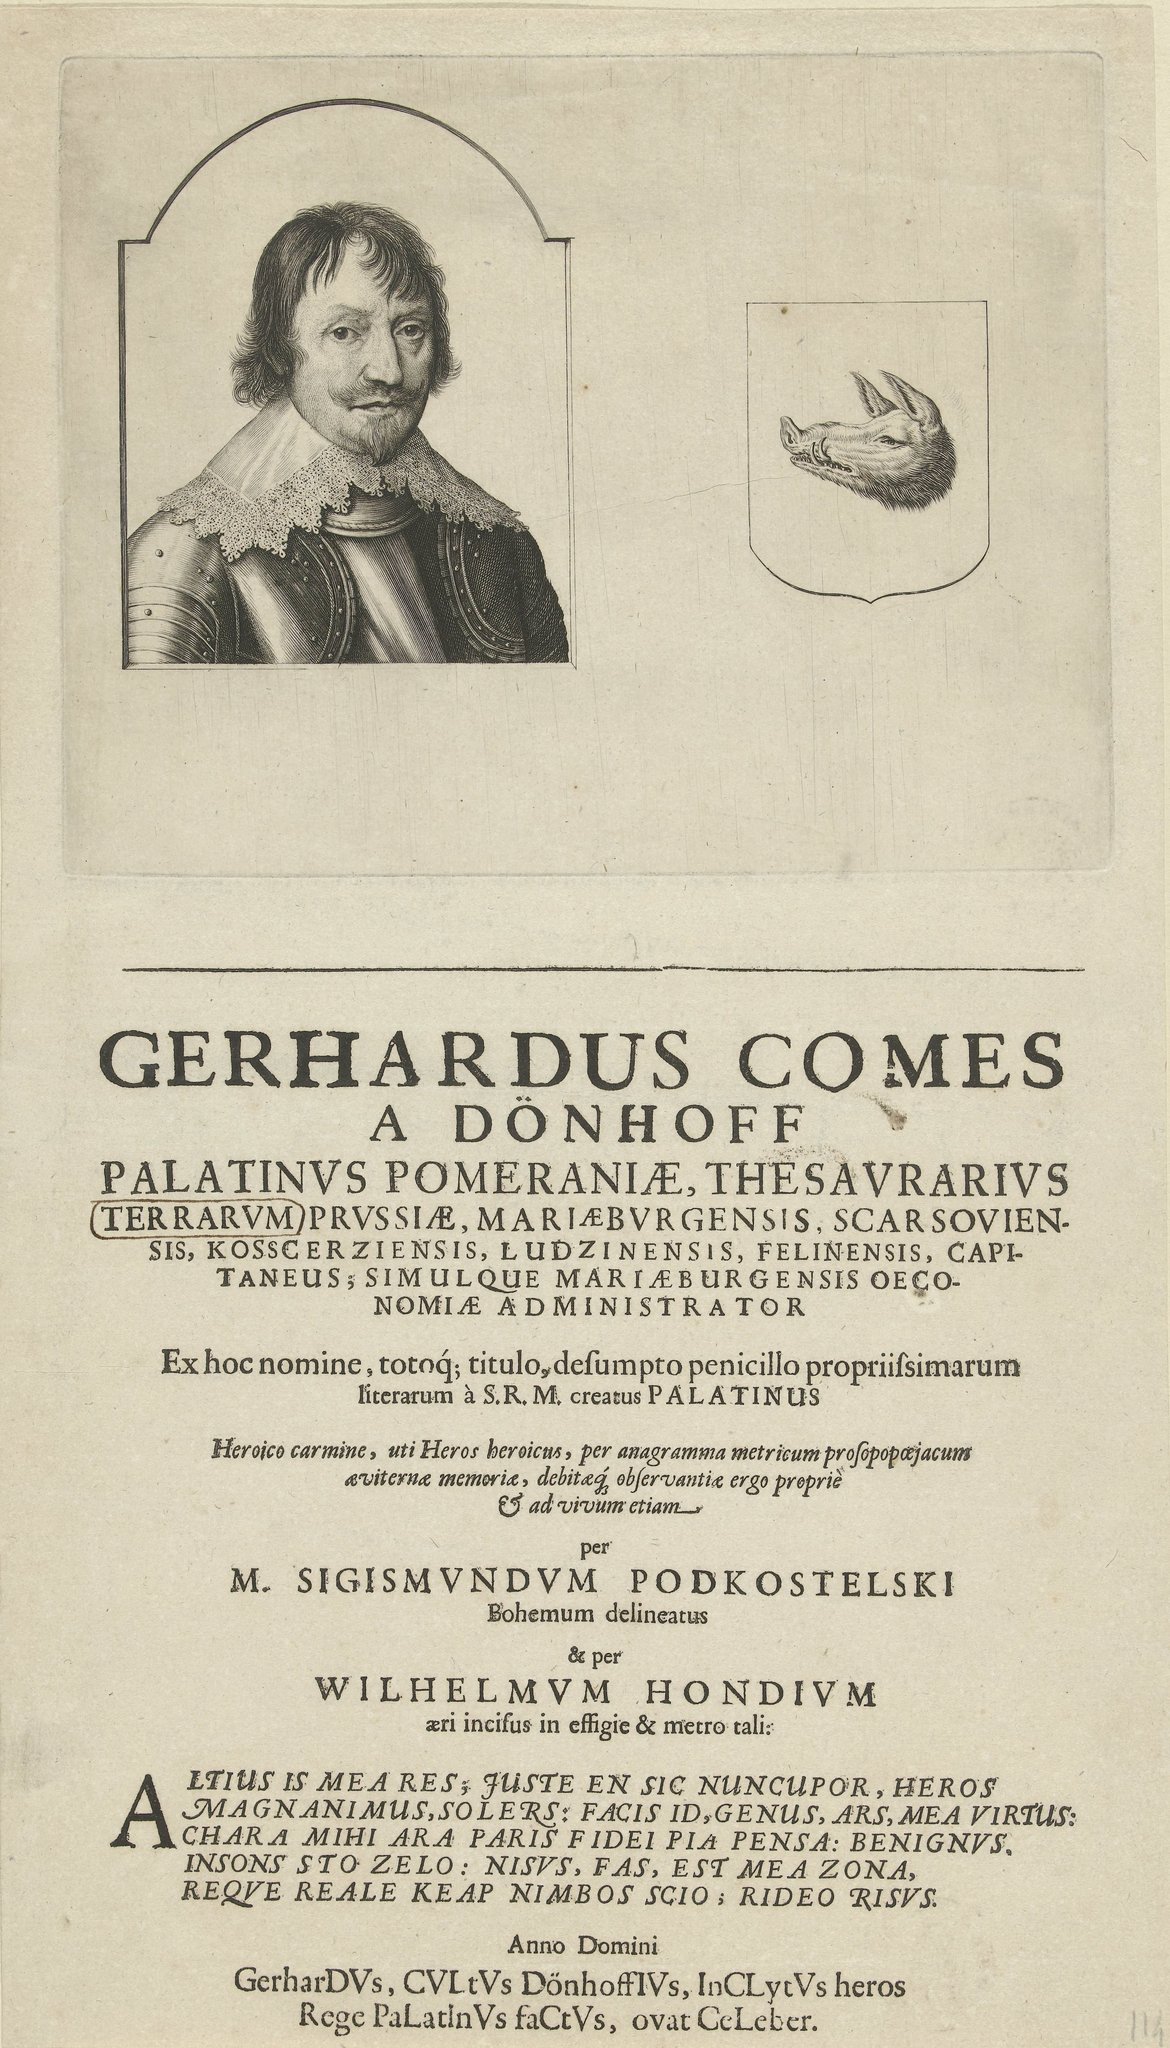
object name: print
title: Portret van Gerard, graaf van Dönhoff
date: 1641-1658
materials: paper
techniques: engraving, letterpress printing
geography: poland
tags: gerard graaf van dönhoff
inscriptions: collector's mark: Lugt 240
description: Buste naar rechts van Gerard, graaf van Dönhoff met rechts van hem zijn familiewapen. Onder het portret een 26-regelige tekst in het Latijn in boekdruk.